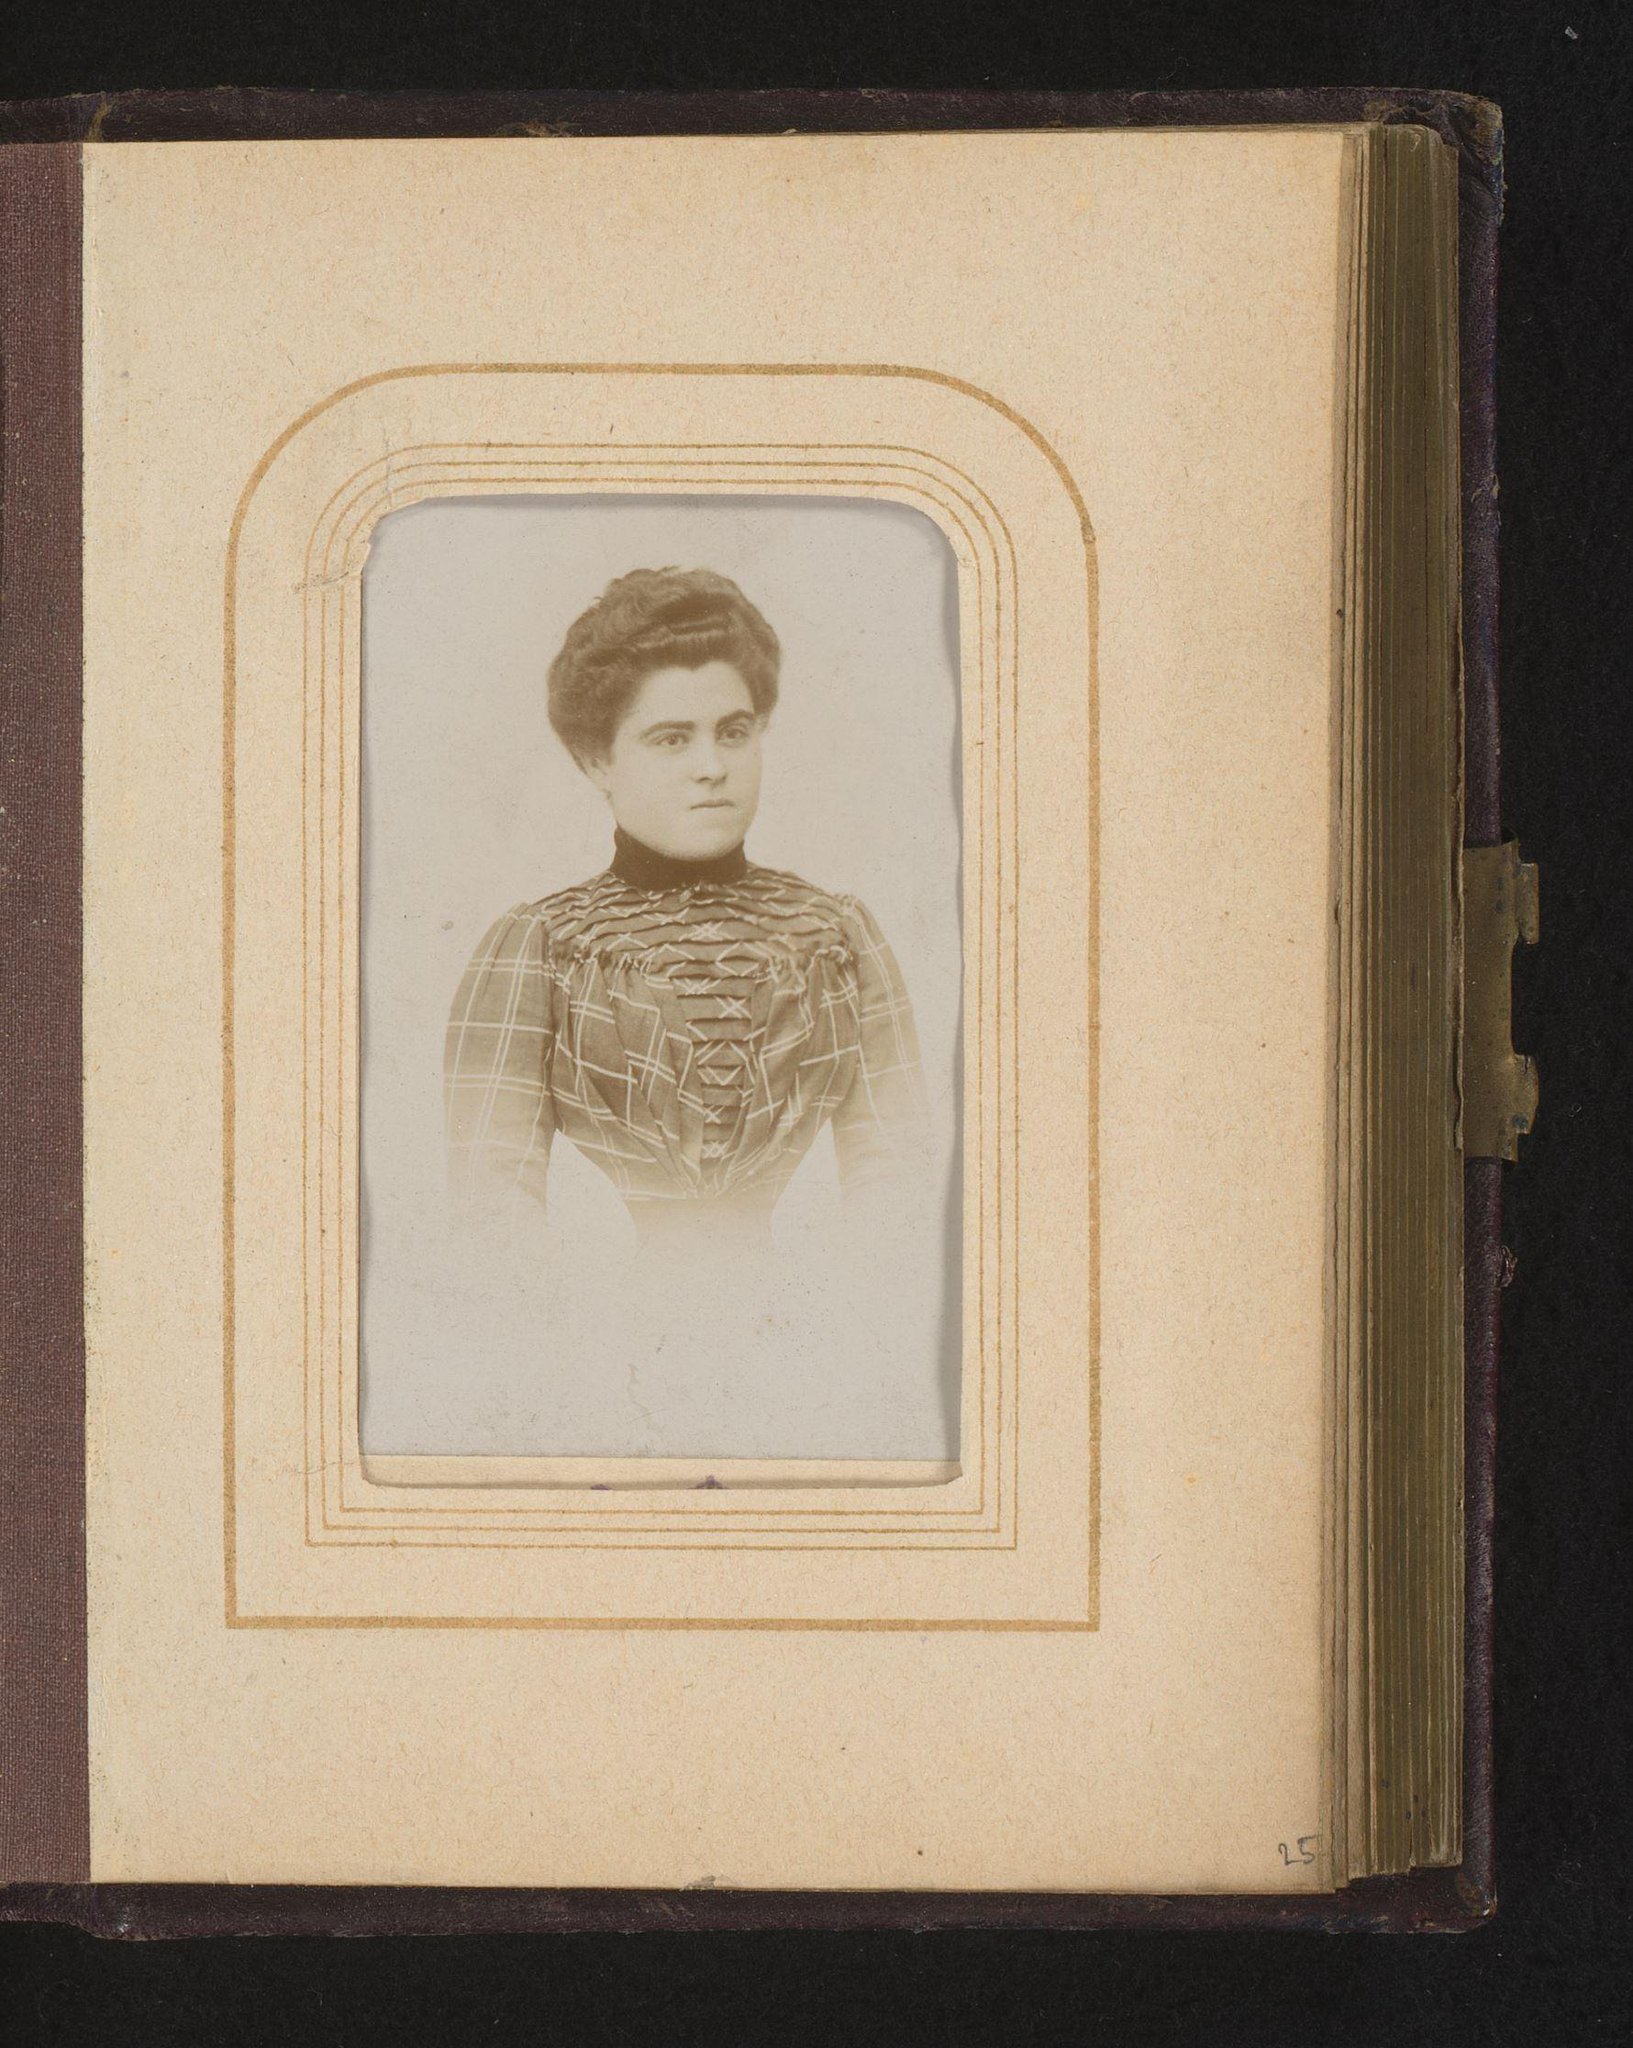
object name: photograph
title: Portret van een jonge vrouw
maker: e. bueno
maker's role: fotograaf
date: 1860-1900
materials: cardboard, photographic support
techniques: albumen print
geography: madrid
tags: adolescent, young woman, maiden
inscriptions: inscription: ‘E. Bueno/ Calle Hortaleza [86]/ Frente à Perez Galdós/ Madrid’